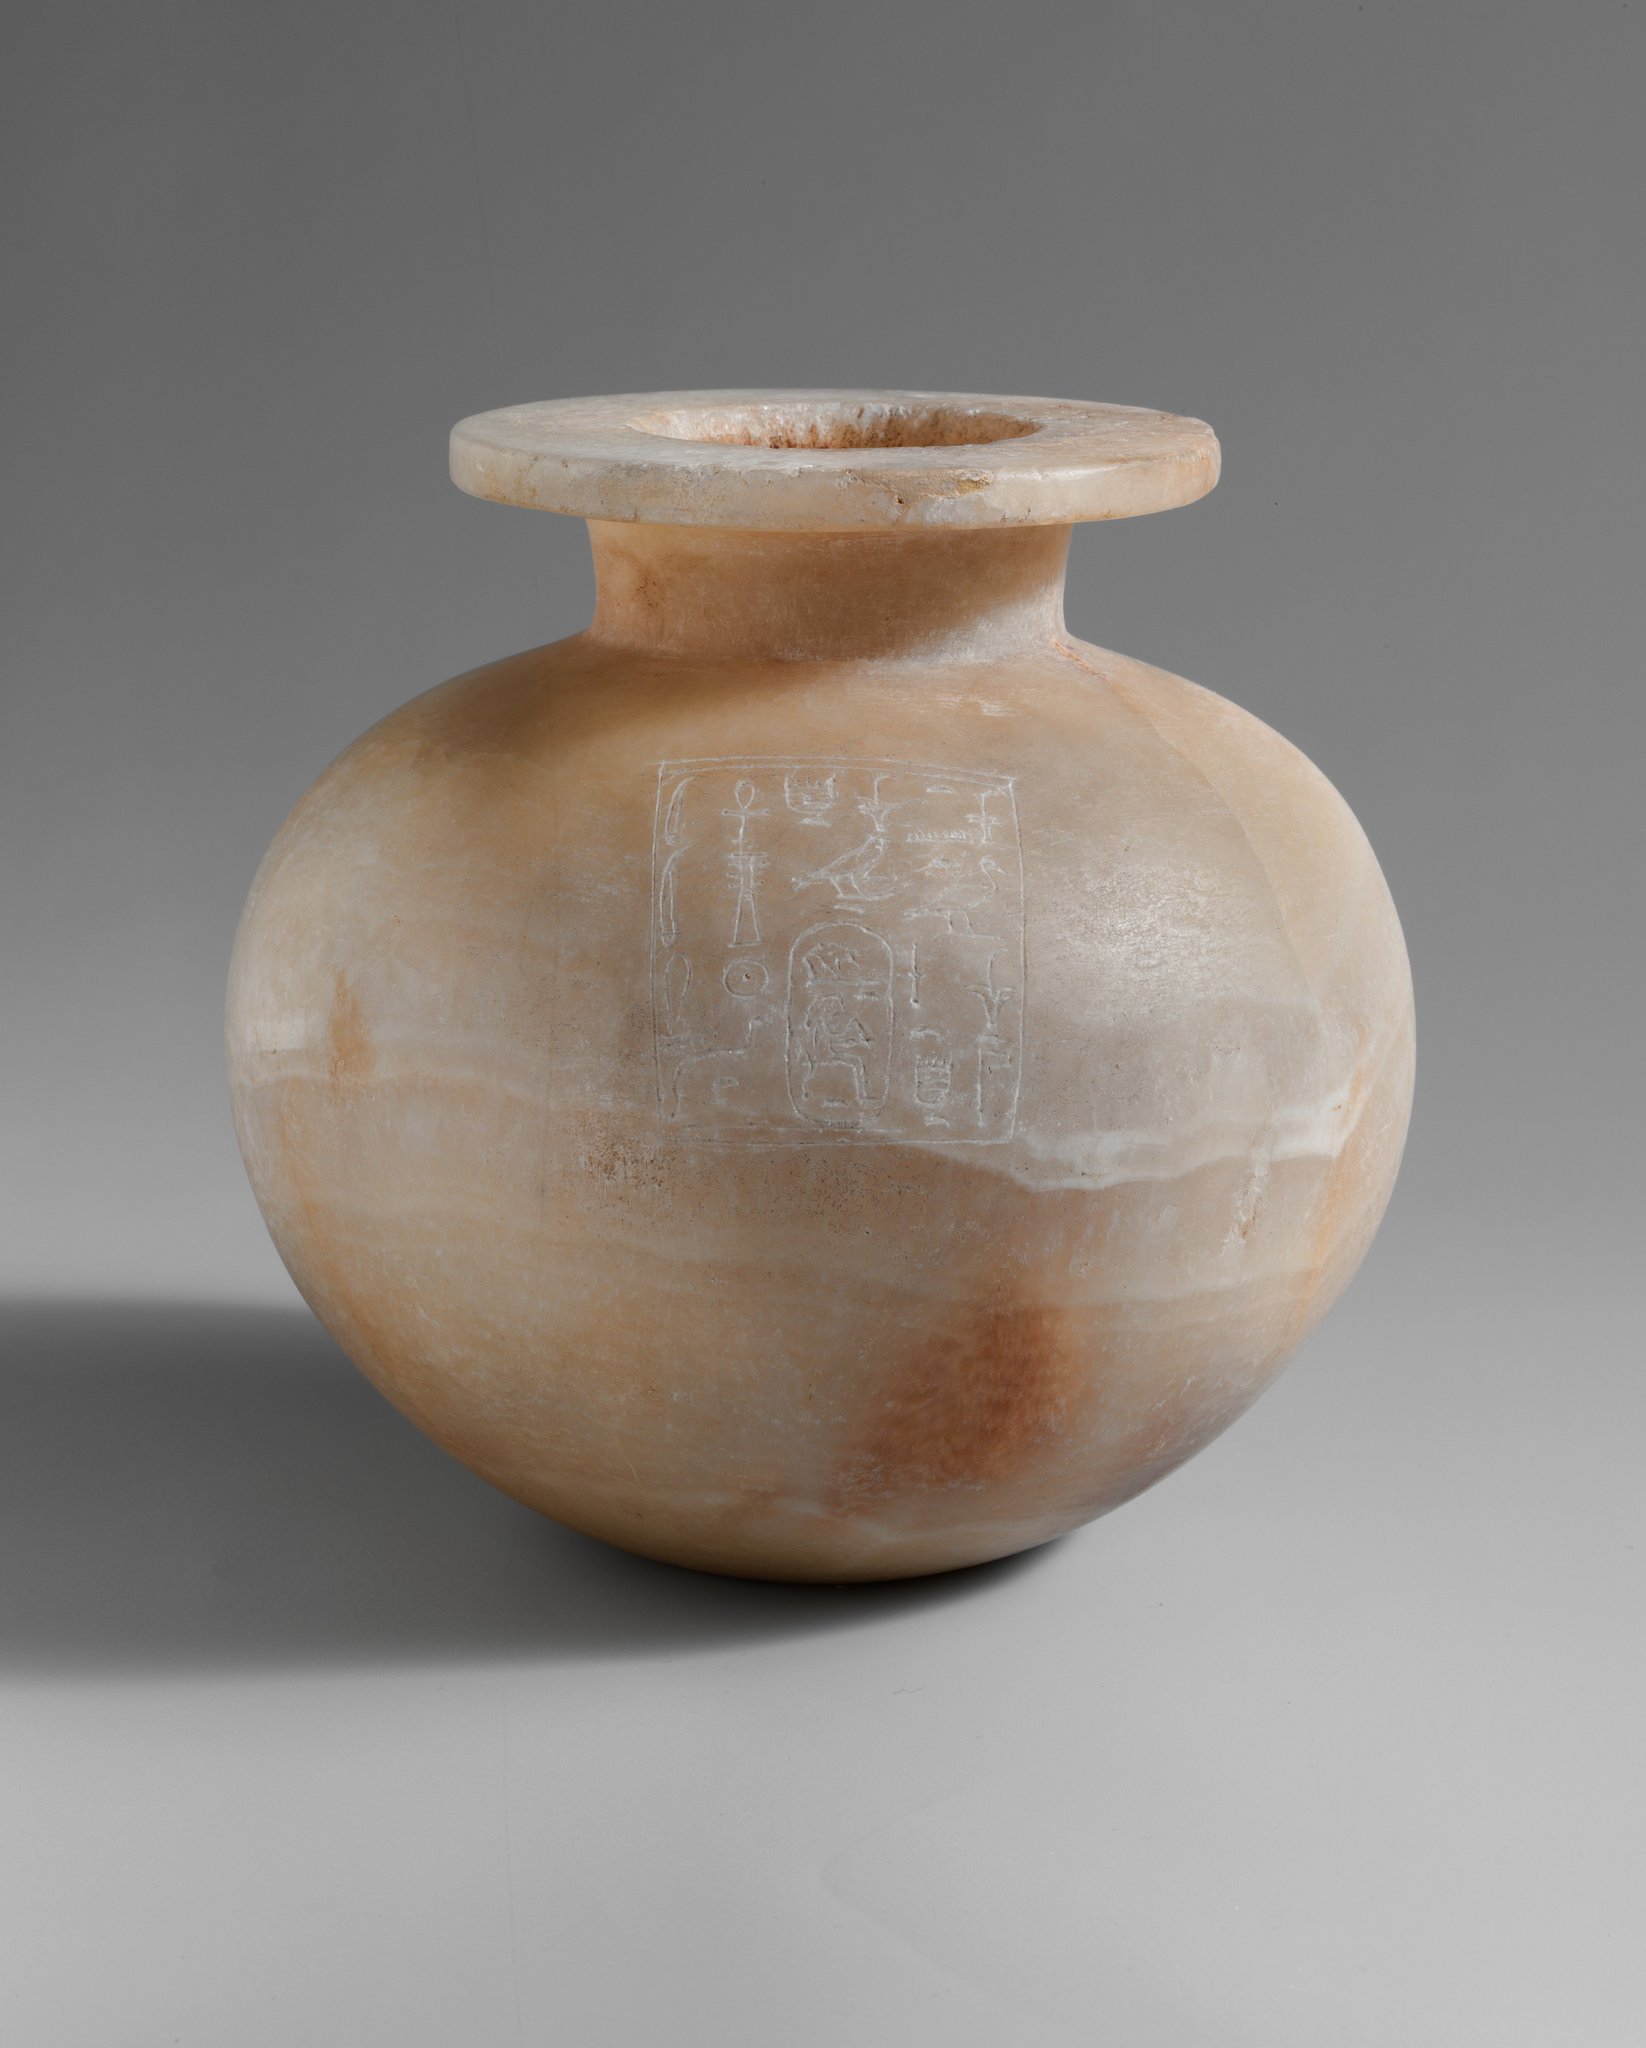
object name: jar, spherical, hatshepsut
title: Spherical Jar Inscribed with Hatshepsut's Titles as Queen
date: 1492-1473 BCE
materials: stone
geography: egypt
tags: hieroglyphs